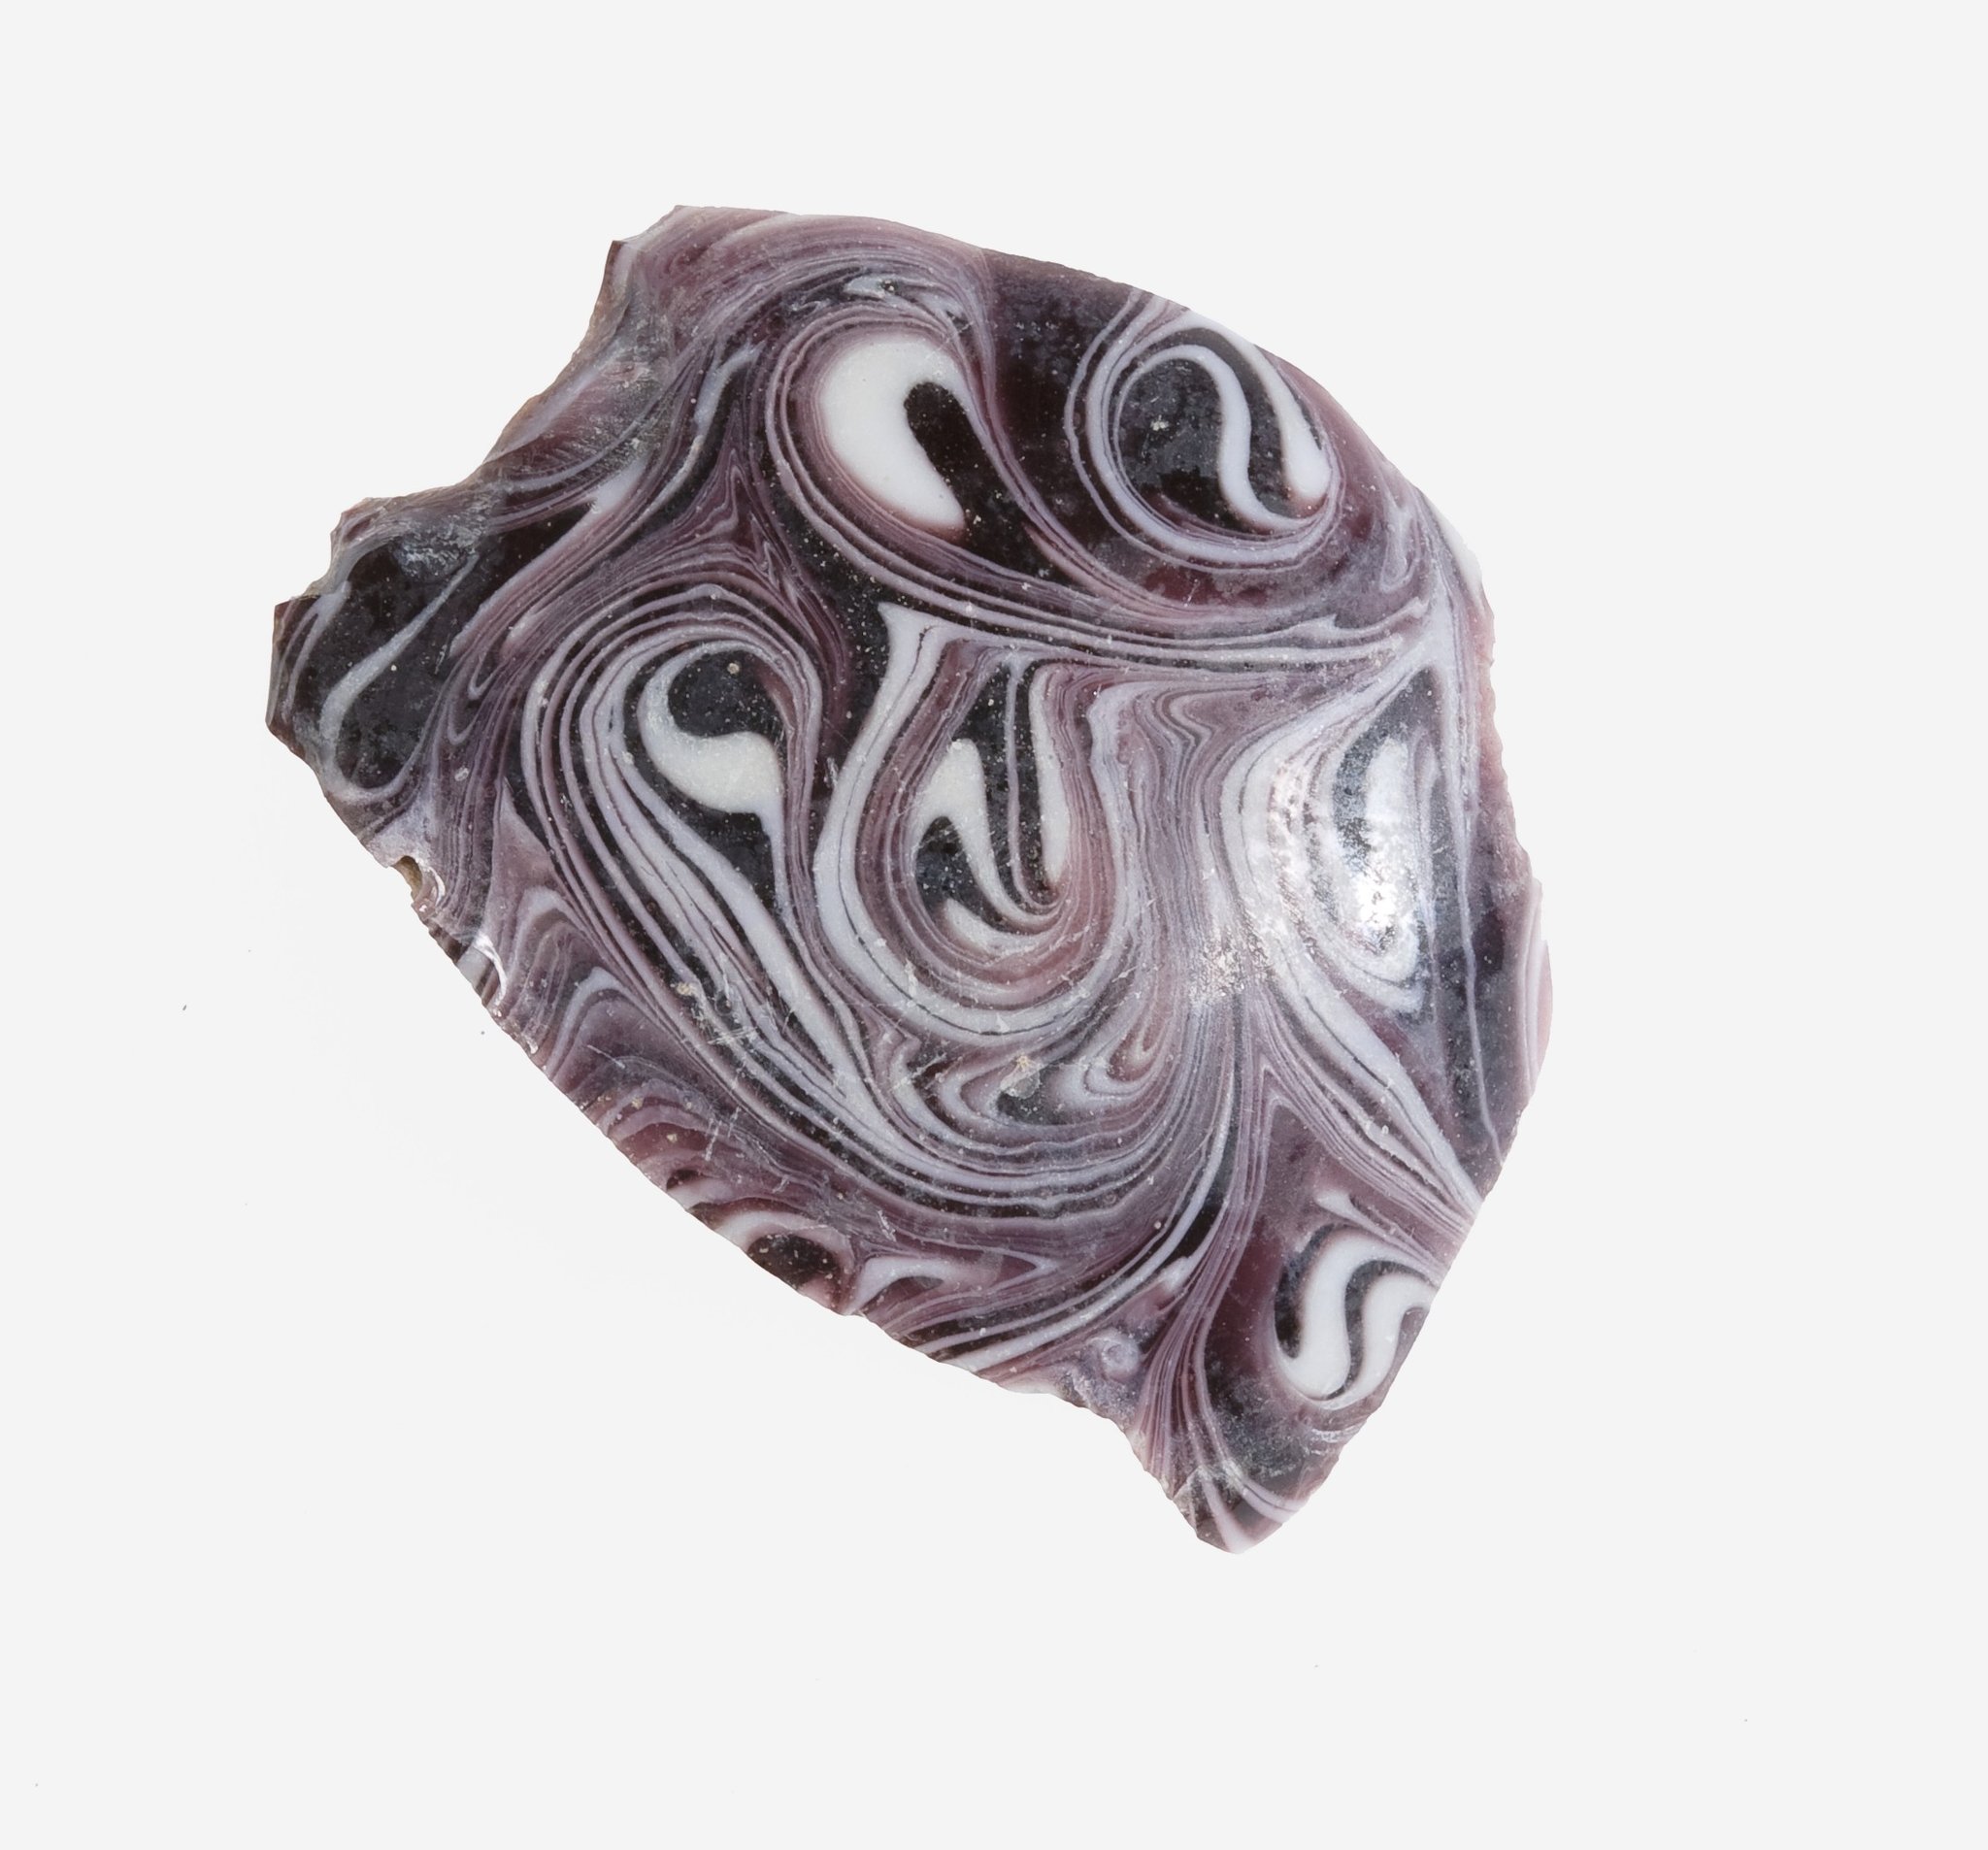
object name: vase fragment, purple white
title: Body Fragment of Vase with Mosaic Pattern in Purple and White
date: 1390-1352 BCE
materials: glass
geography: egypt